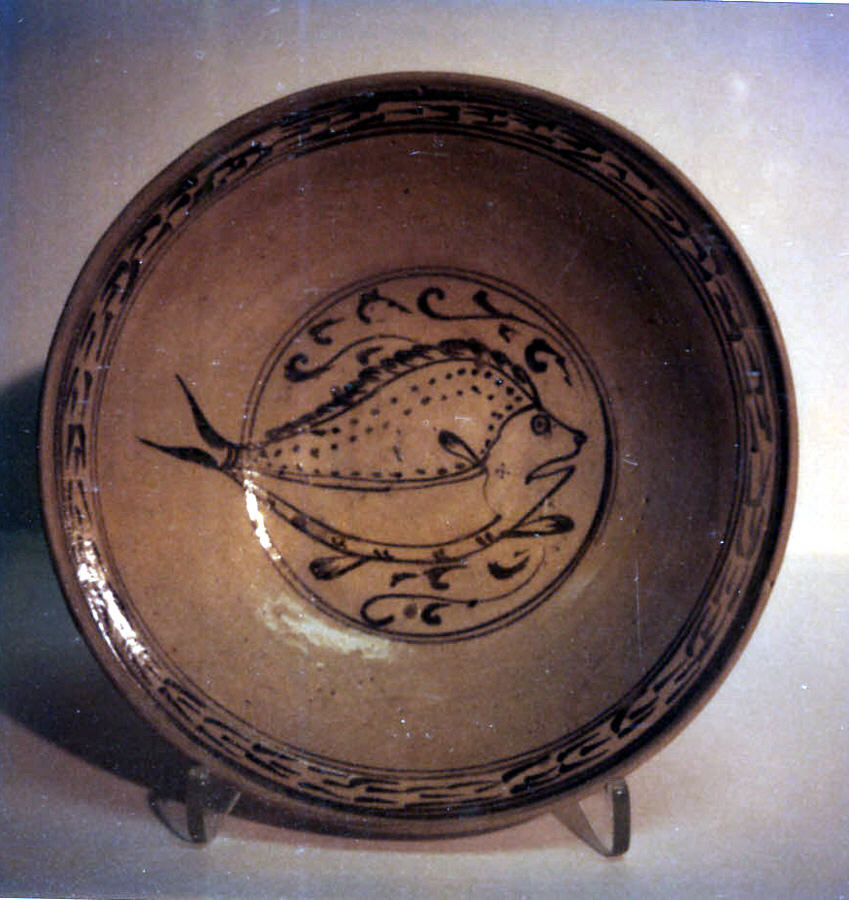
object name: dish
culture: thailand, sukhothai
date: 1401-1600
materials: iron, stoneware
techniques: underglaze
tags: fish